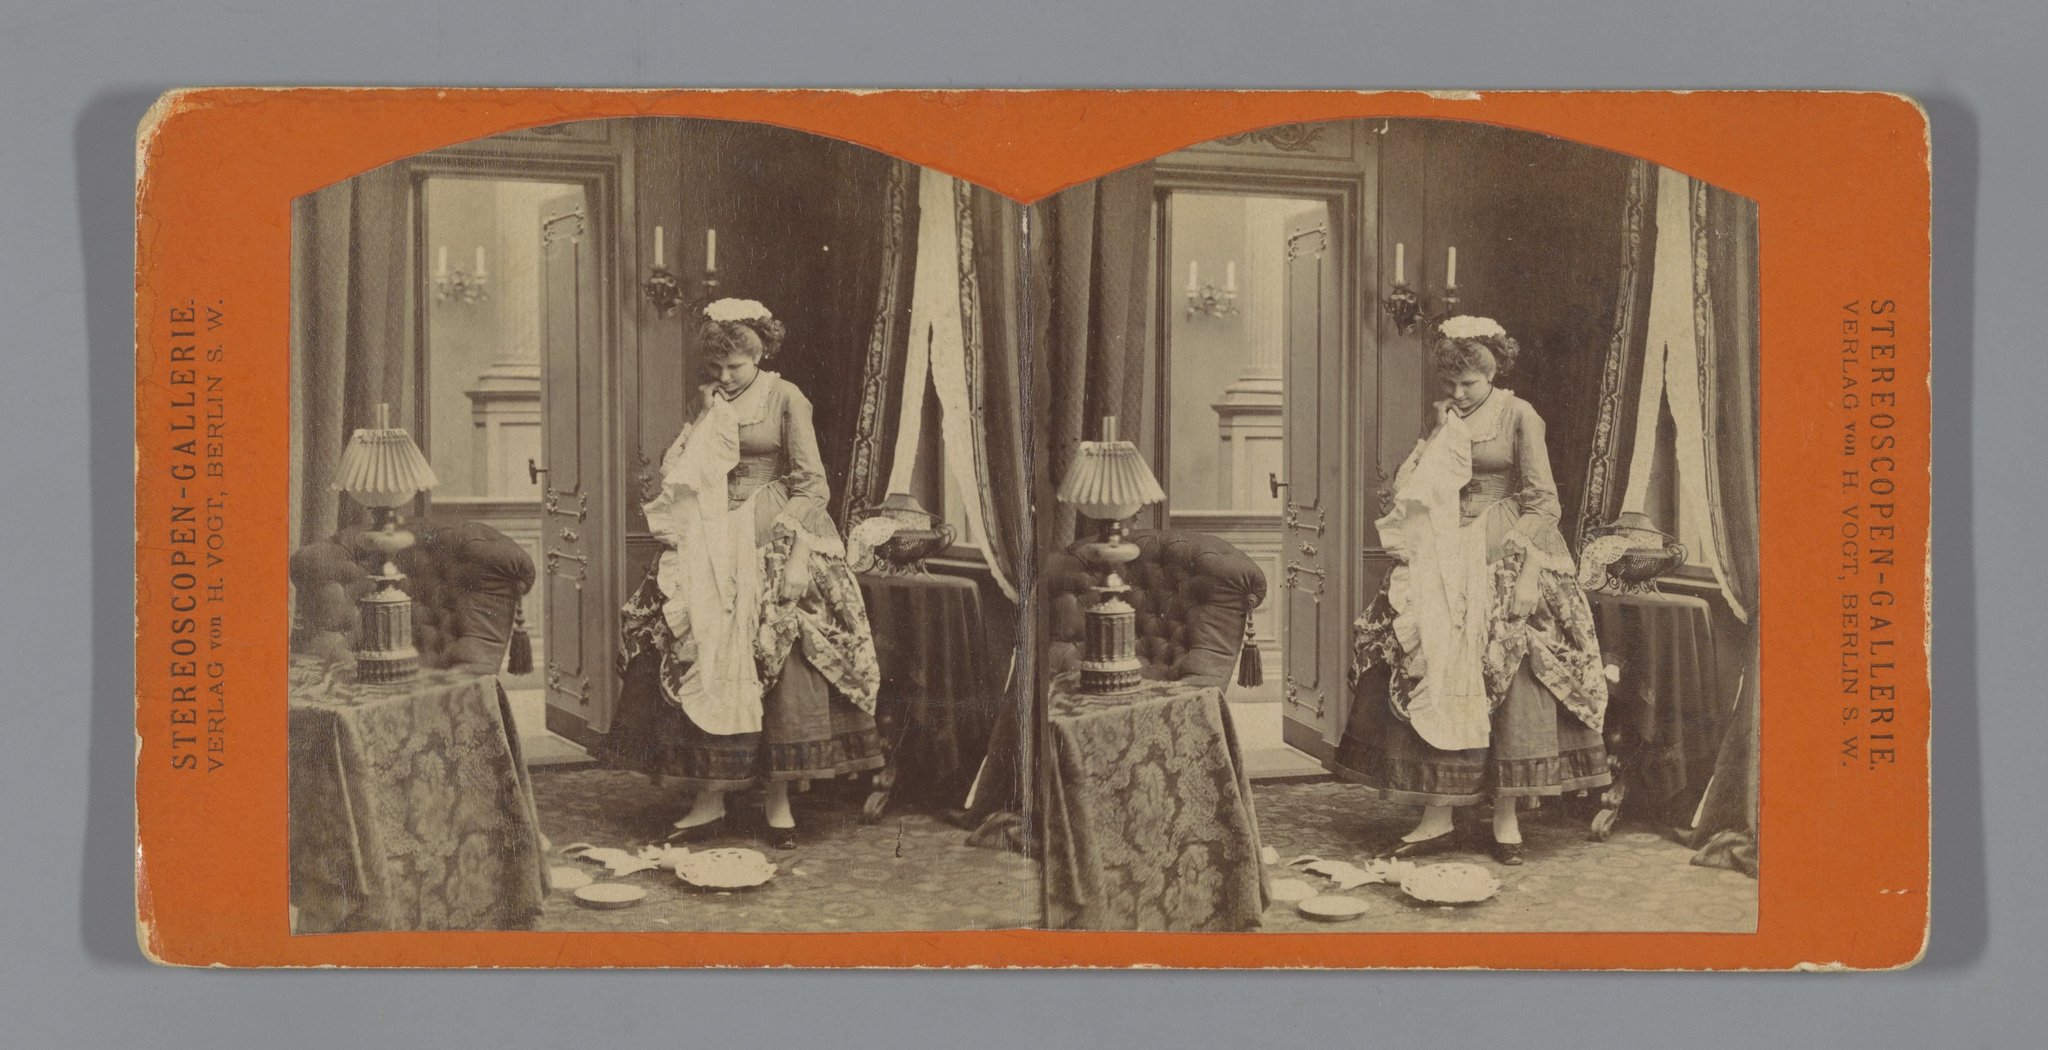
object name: stereograph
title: Jonge vrouw in woonkamer met gebroken servies op de grond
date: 1870-1880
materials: cardboard, photographic support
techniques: albumen print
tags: 41c34(+9) dinner-service (+ broken, damaged tableware, etc.), living-room, parlour, sitting-room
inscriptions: : ‘Stereoscopen-Gallerie. Berlin S.W.’